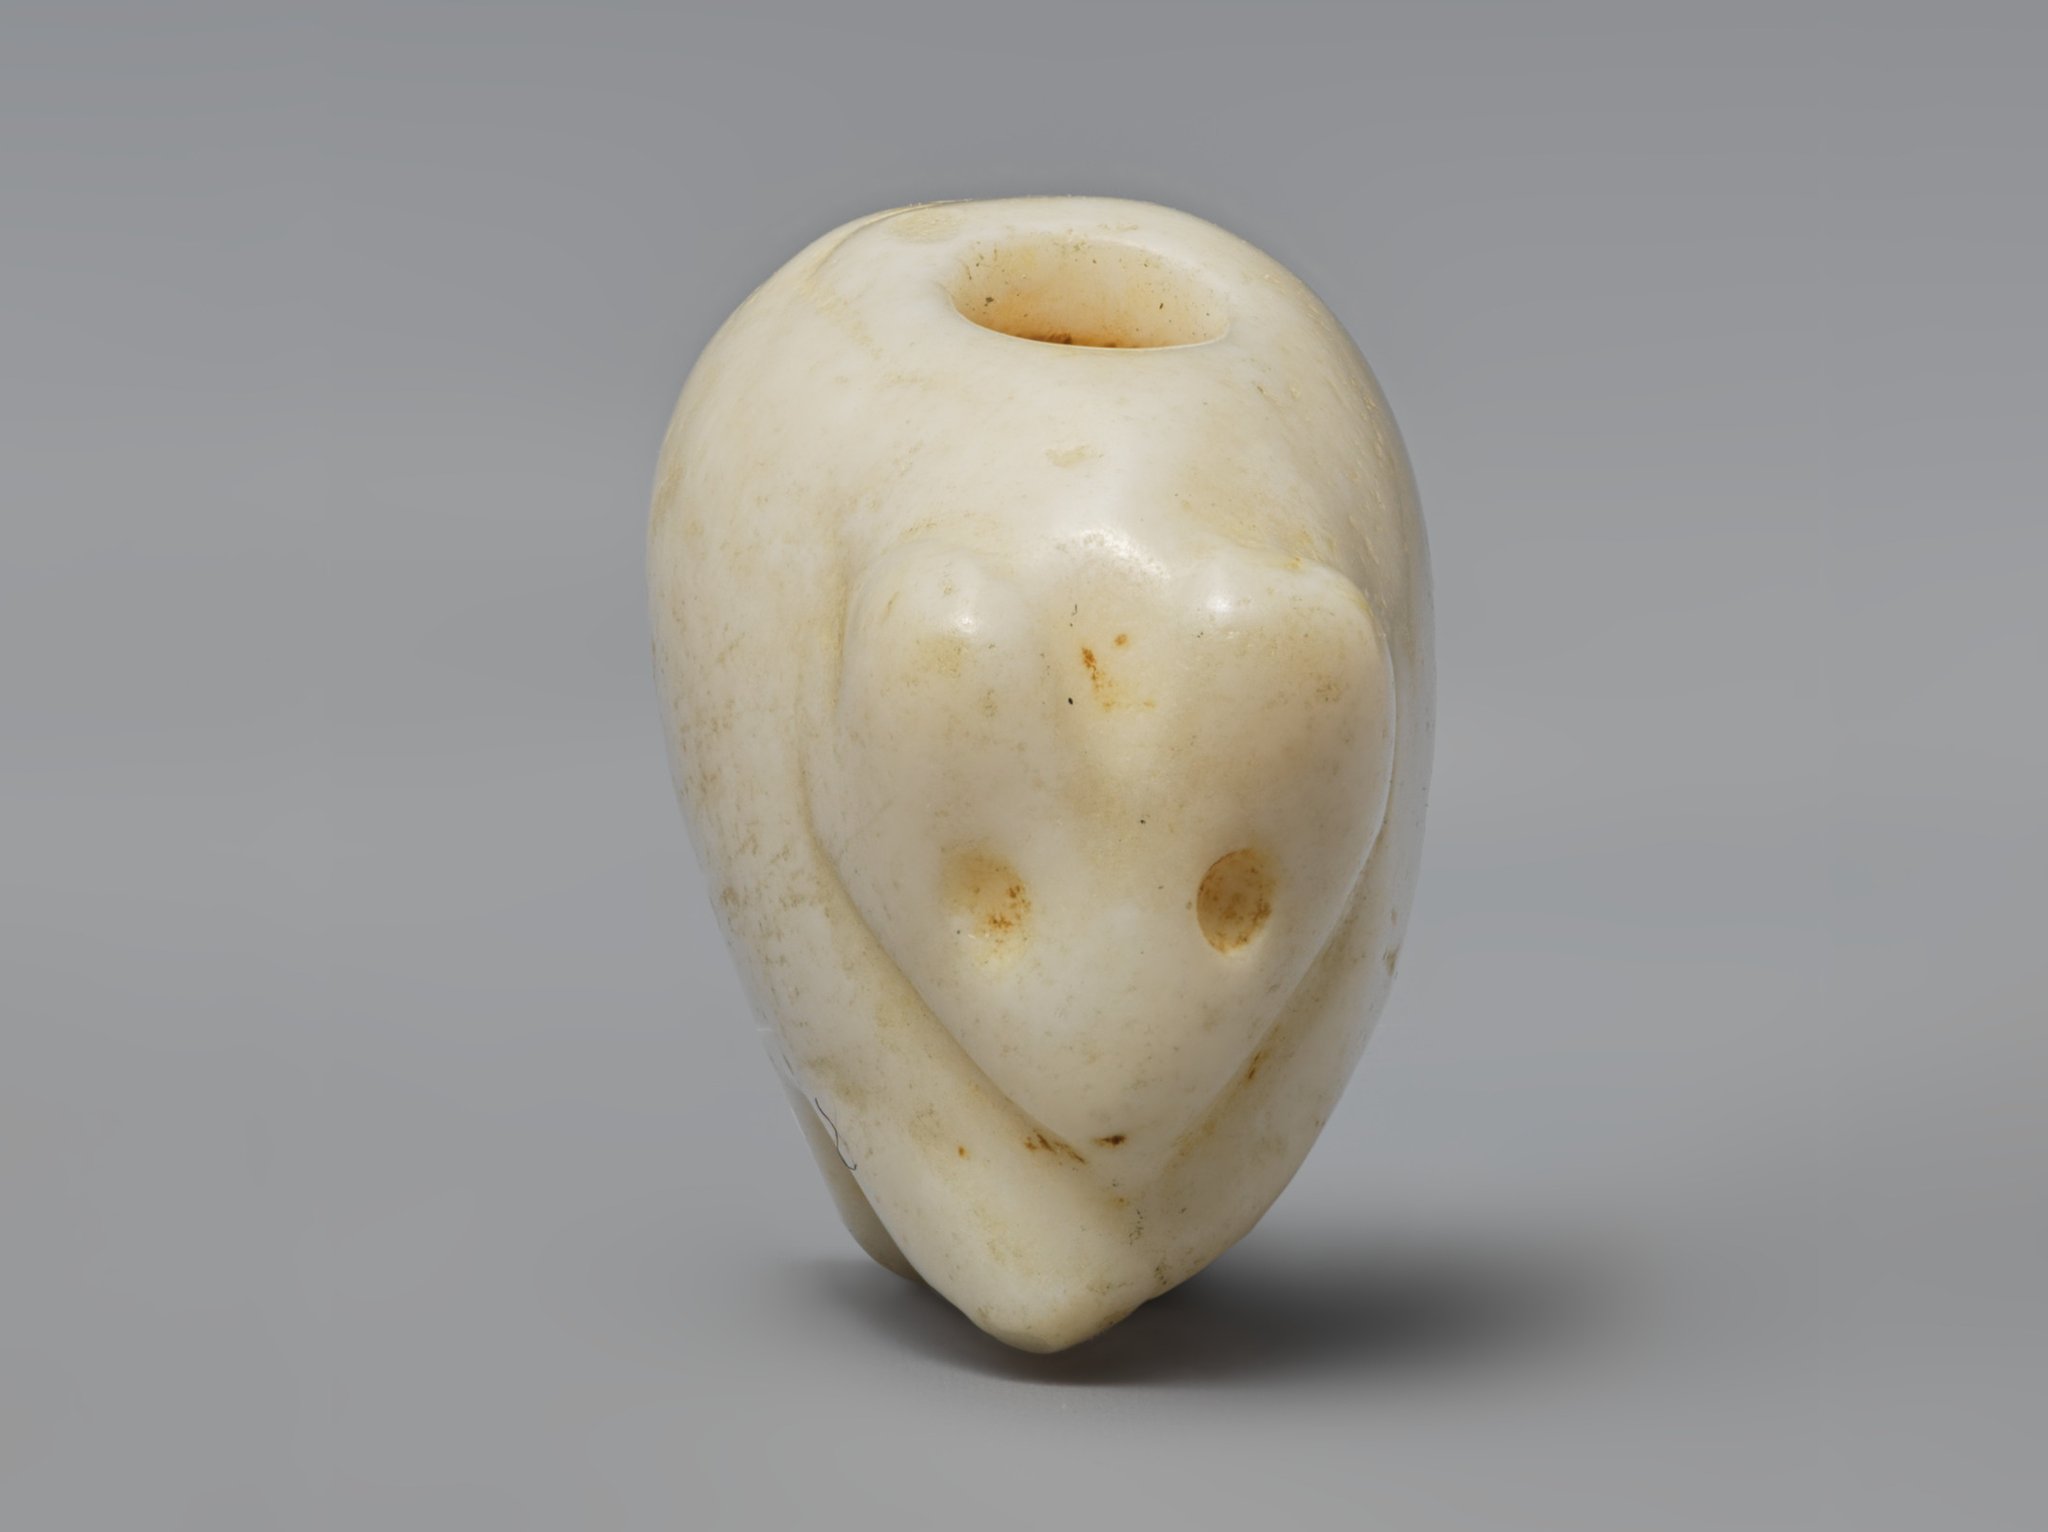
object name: necklace, bead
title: Amulet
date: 3000 BCE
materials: stone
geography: syria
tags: animals